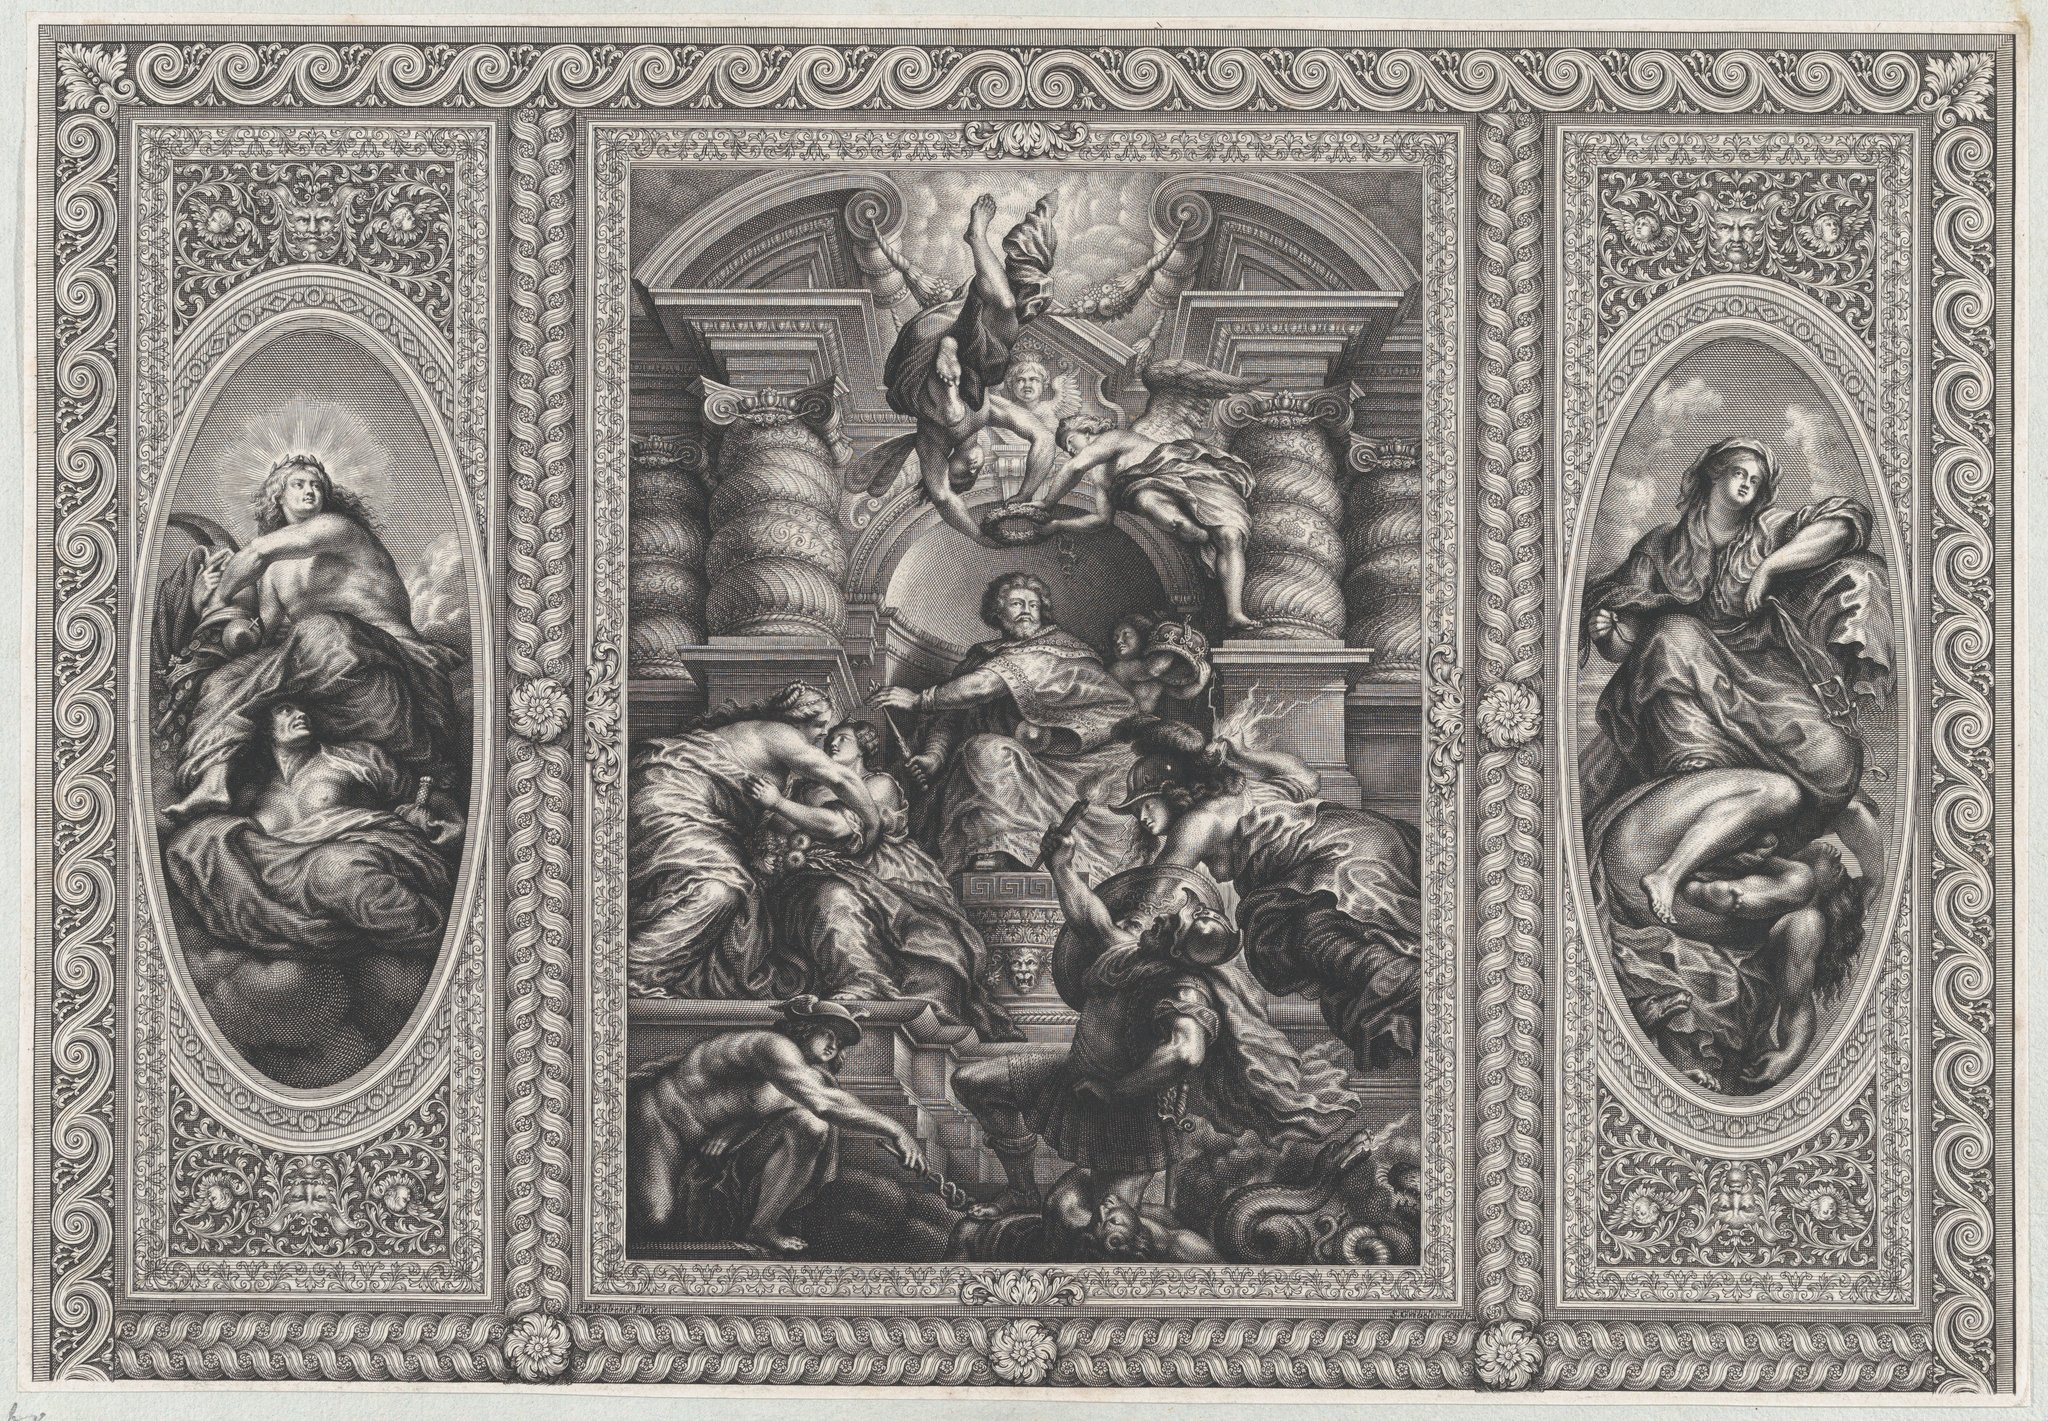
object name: print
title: James I appointing Charles as King of Scotland at center, Minerva spearing Ignorance at right, and Hercules beating Envy at left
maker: simon gribelin ii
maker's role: artist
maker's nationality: french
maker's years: 1661-1733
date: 1720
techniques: engraving